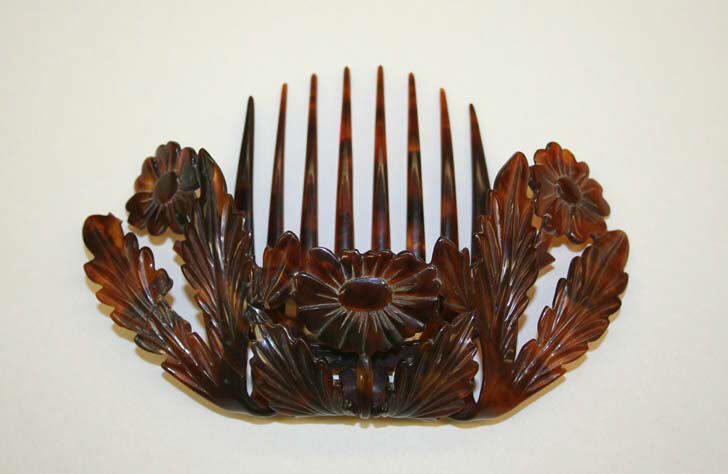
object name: comb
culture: american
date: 1870-1879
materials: metal, shell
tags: flowers